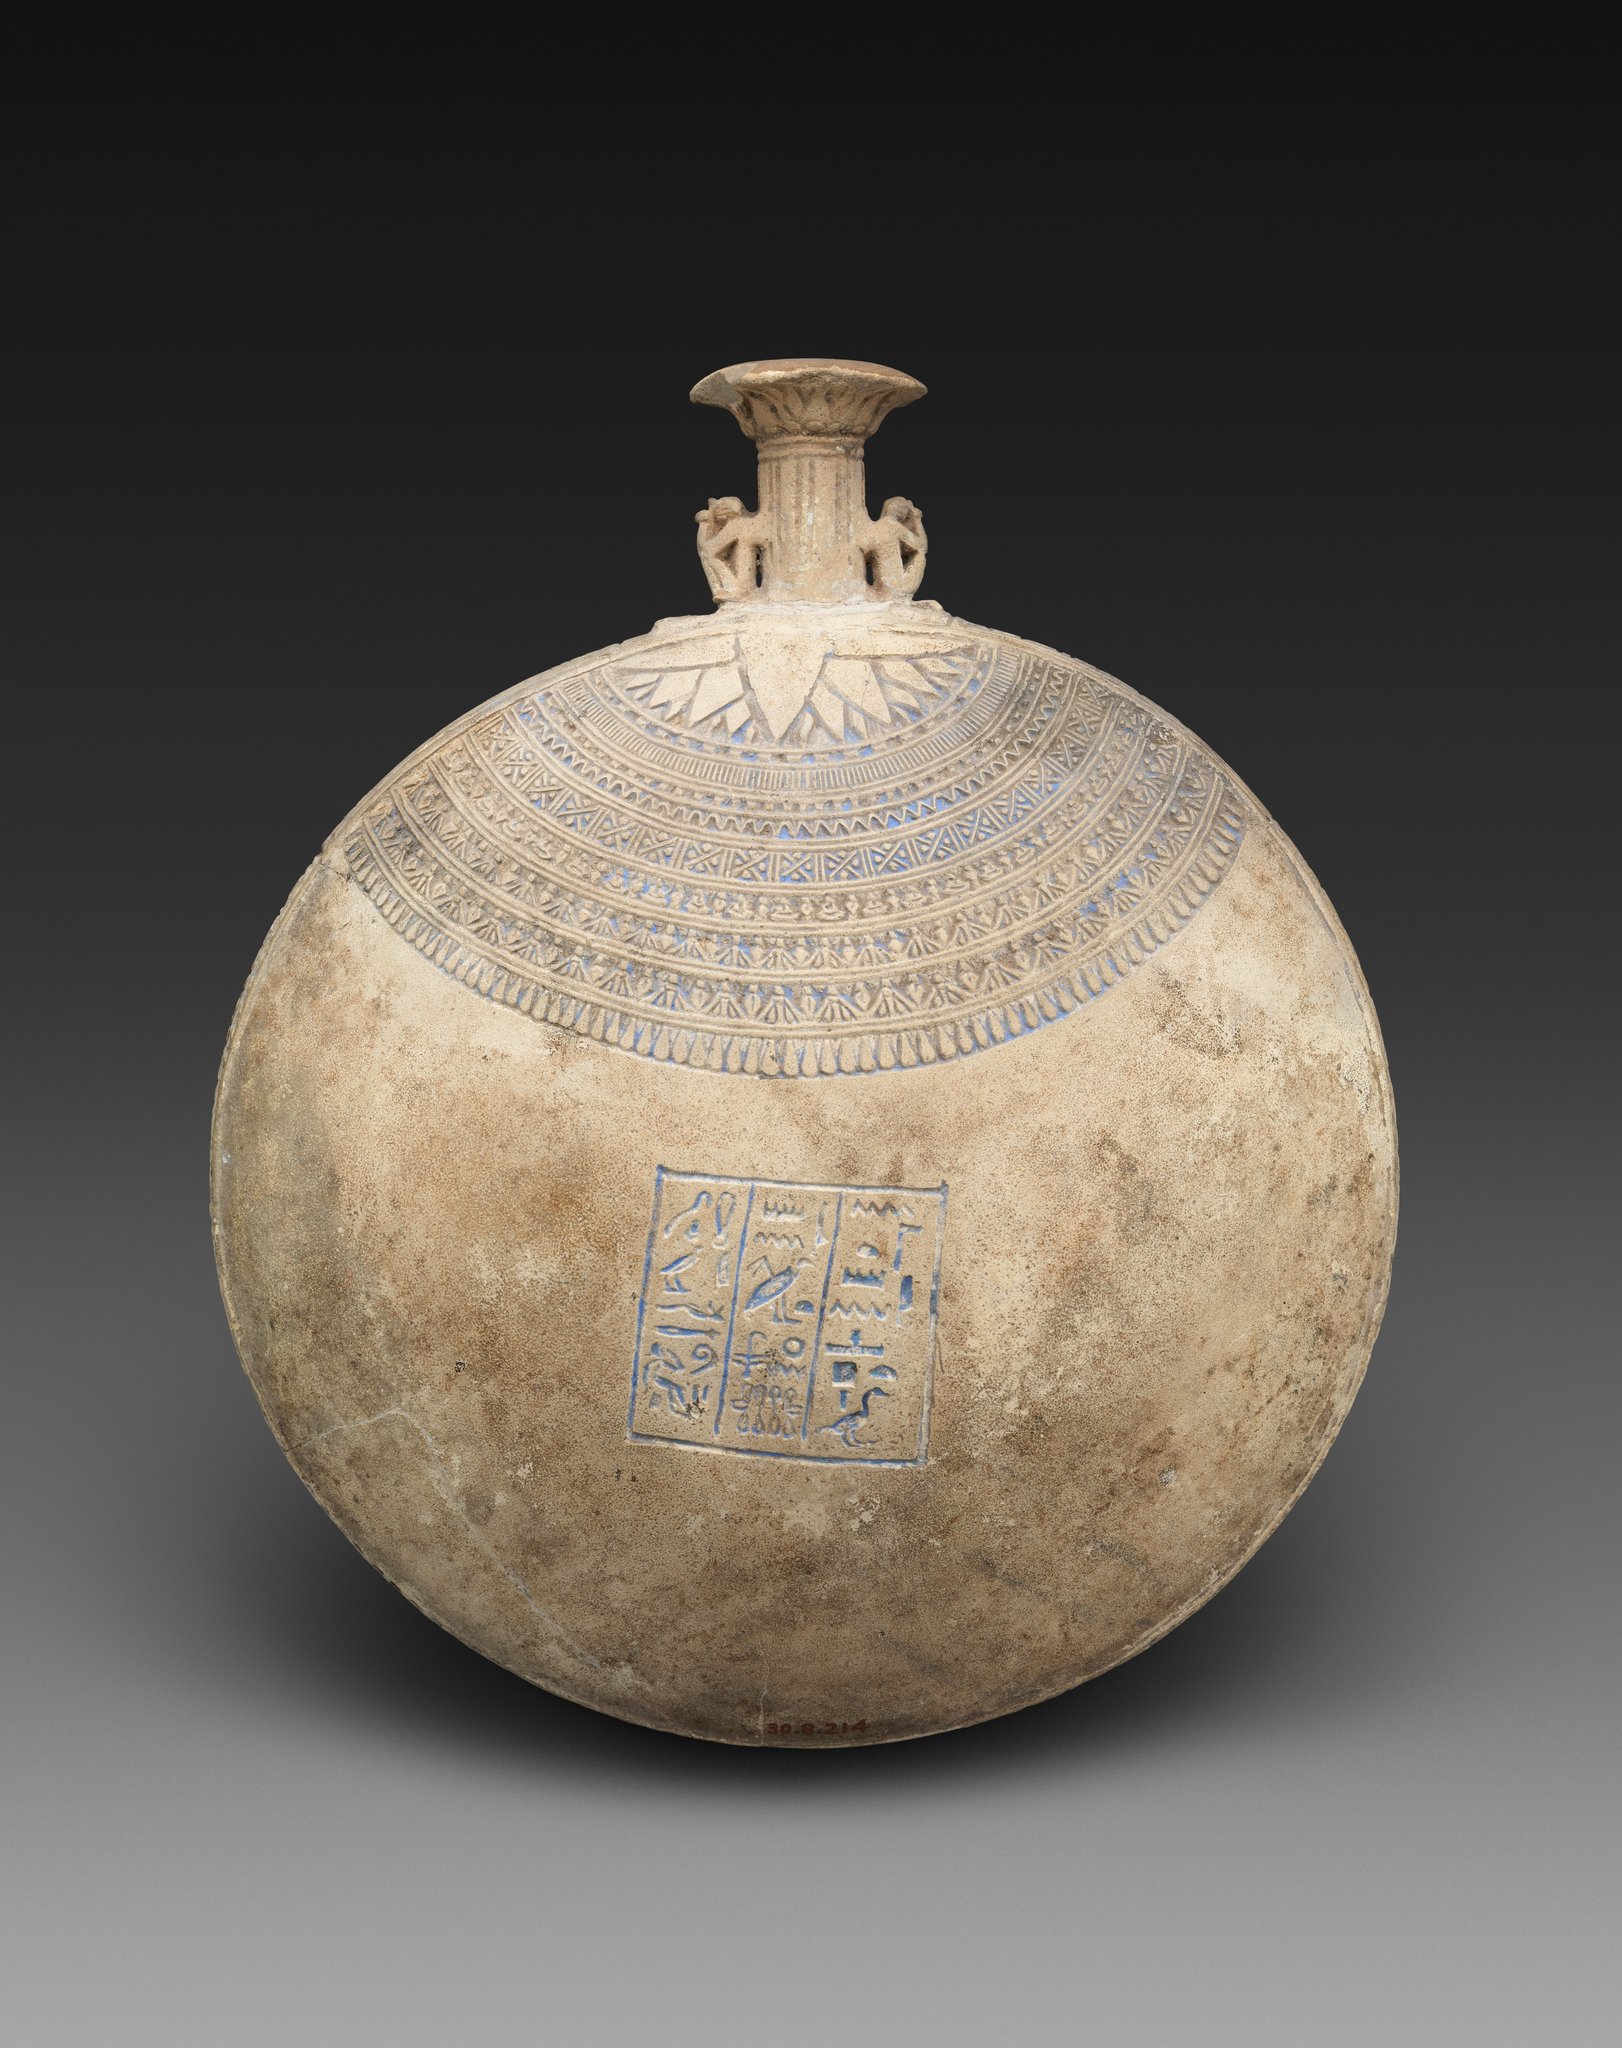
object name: bottle, new year's bottle, amenhotep, iufaa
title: Lentoid Bottle ("New Year's Bottle") inscribed for the God's Father Amenhotep, son of the God's Father Iufaa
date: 664-525 BCE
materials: faience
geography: egypt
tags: hieroglyphs